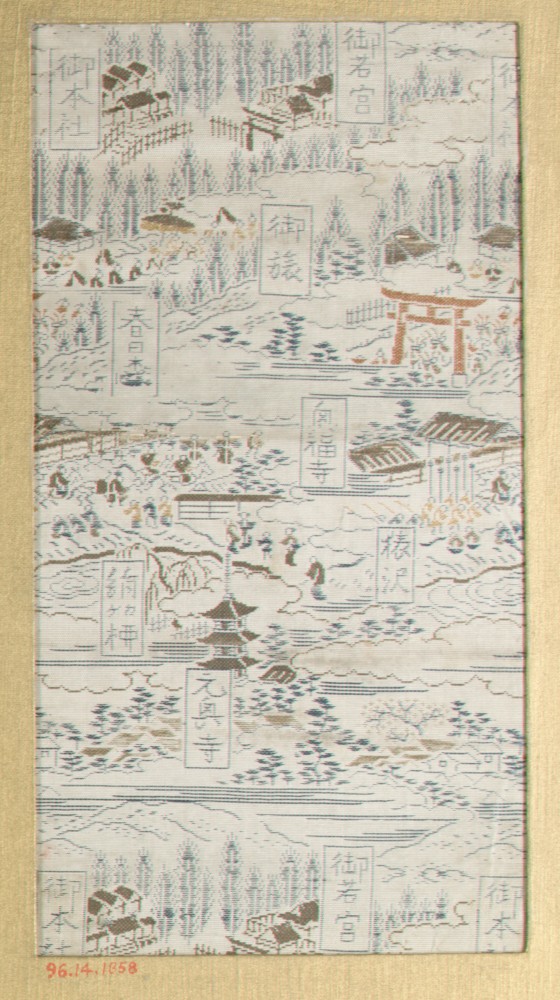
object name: piece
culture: japanese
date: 1701-1900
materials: silk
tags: landscapes